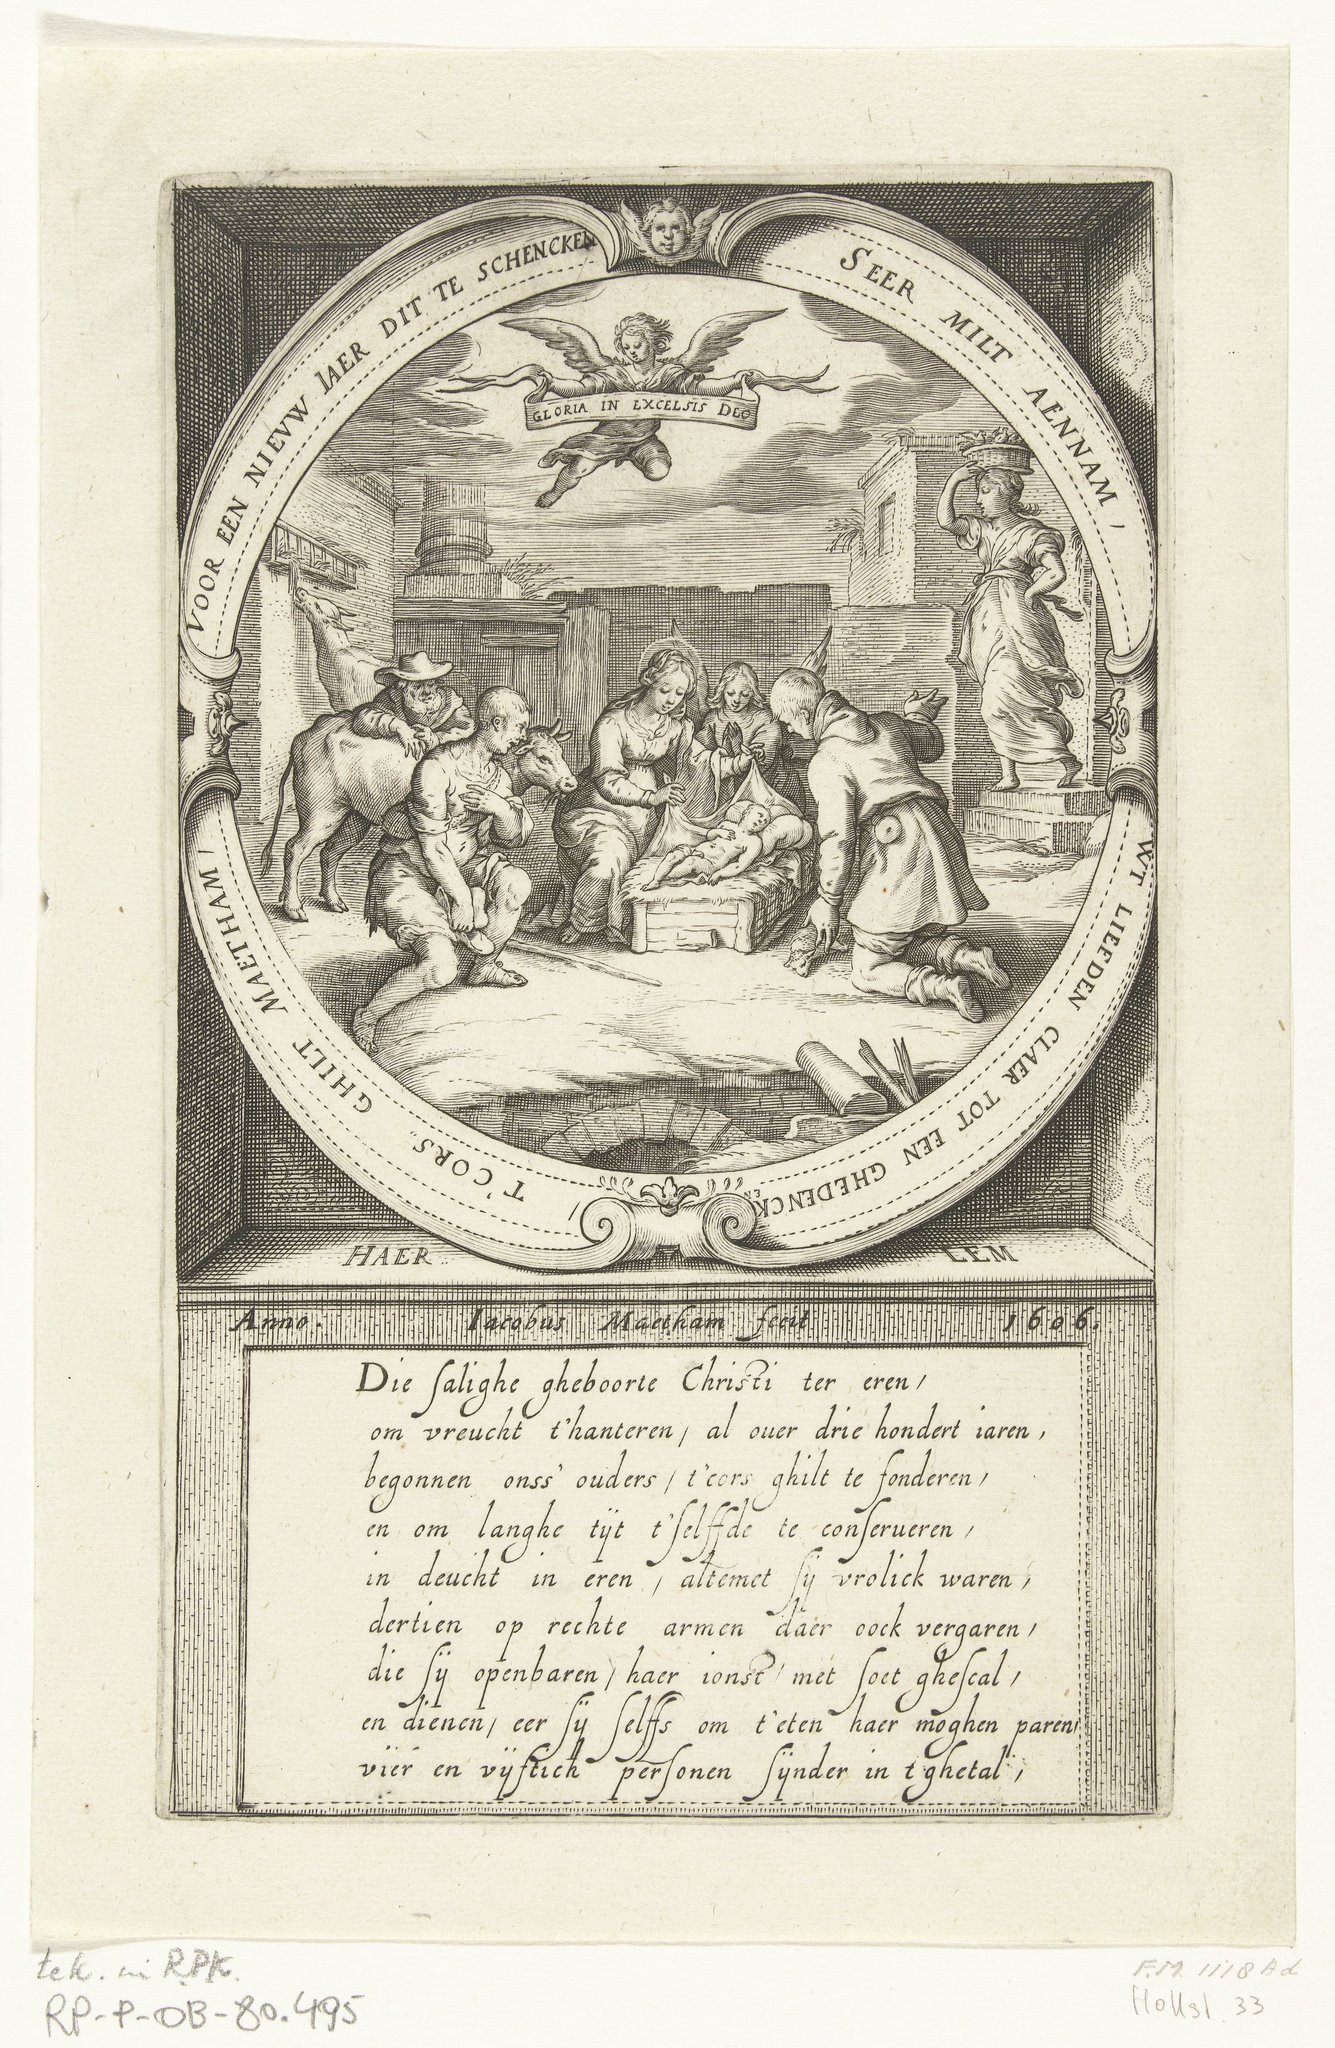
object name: print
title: Nieuwjaarsprent van de Haarlemse Kerstgilde, 1606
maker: jacob matham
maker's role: draughtsman, print maker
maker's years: 1571-1631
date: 1606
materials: paper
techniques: engraving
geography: northern netherlands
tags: adoration of the christ-child by the shepherds; mary and joseph present, haarlem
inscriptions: date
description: Nieuwjaarsprent van de Haarlemse Kerstgilde of Heilig Kerstmisgilde, 1606. De aanbidding van het kind door de herders, in cartouche met opdracht in het randschrift. Met onderschrift van 9 regels in het Nederlands.